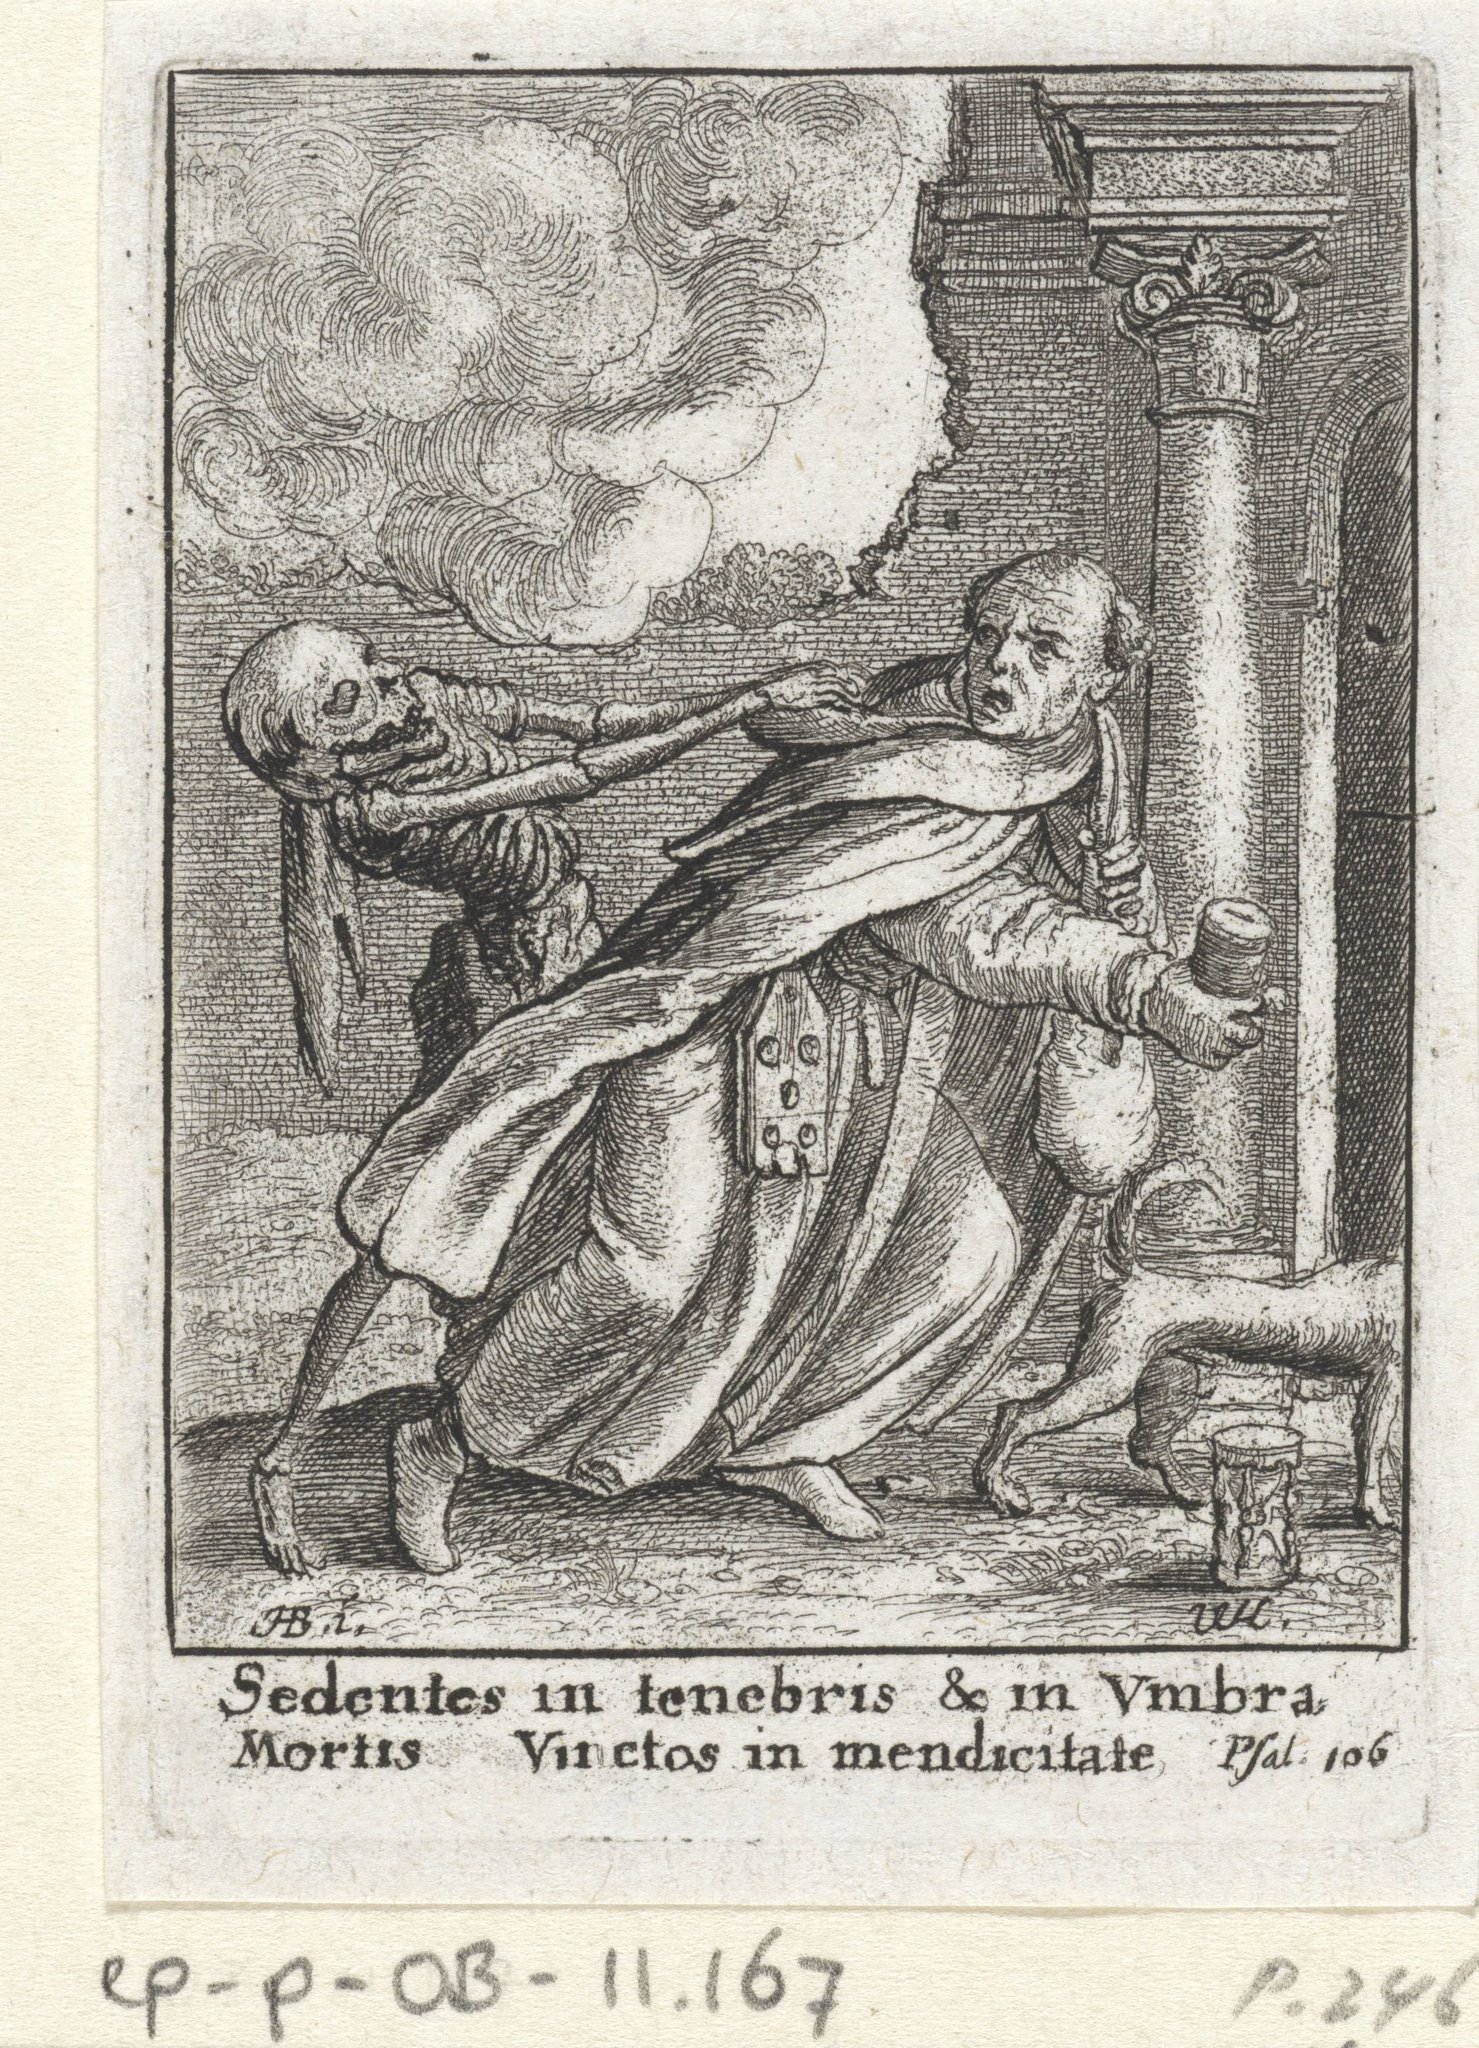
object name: book illustration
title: De monnik en de Dood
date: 1680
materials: paper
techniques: etching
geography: antwerp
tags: dance of death; death together with one or more human beings, monk(s), friar(s), hourglass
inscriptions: collector's mark: Lugt 240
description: De Dood trekt de monnik aan zijn pij. Voor hem op de grond staat een zandloper.